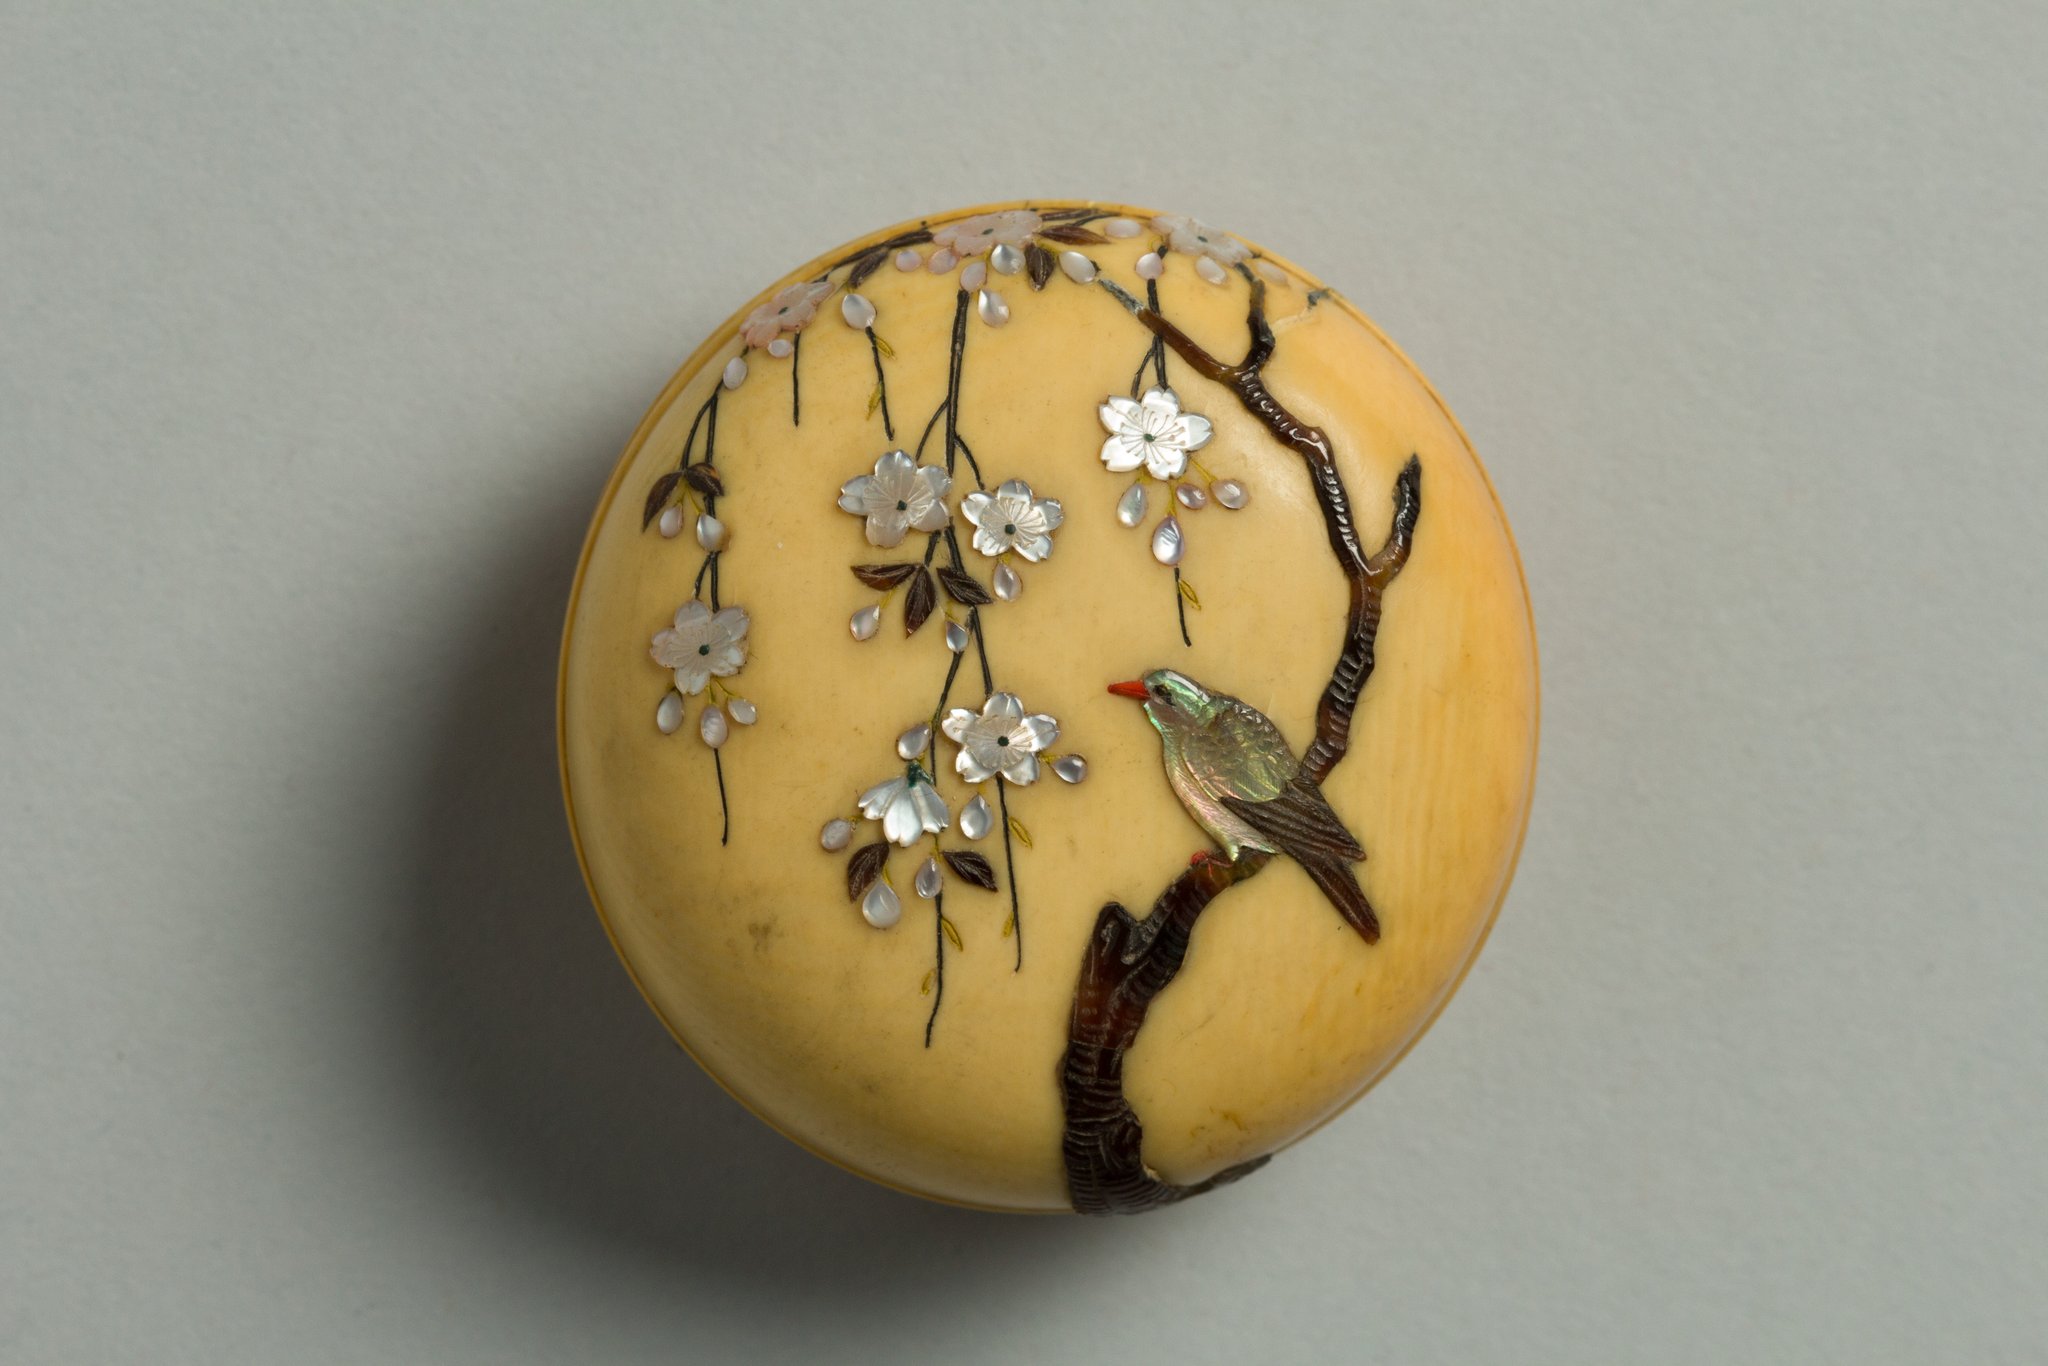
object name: netsuke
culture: japanese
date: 1801-1900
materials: ivory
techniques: inlay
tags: birds